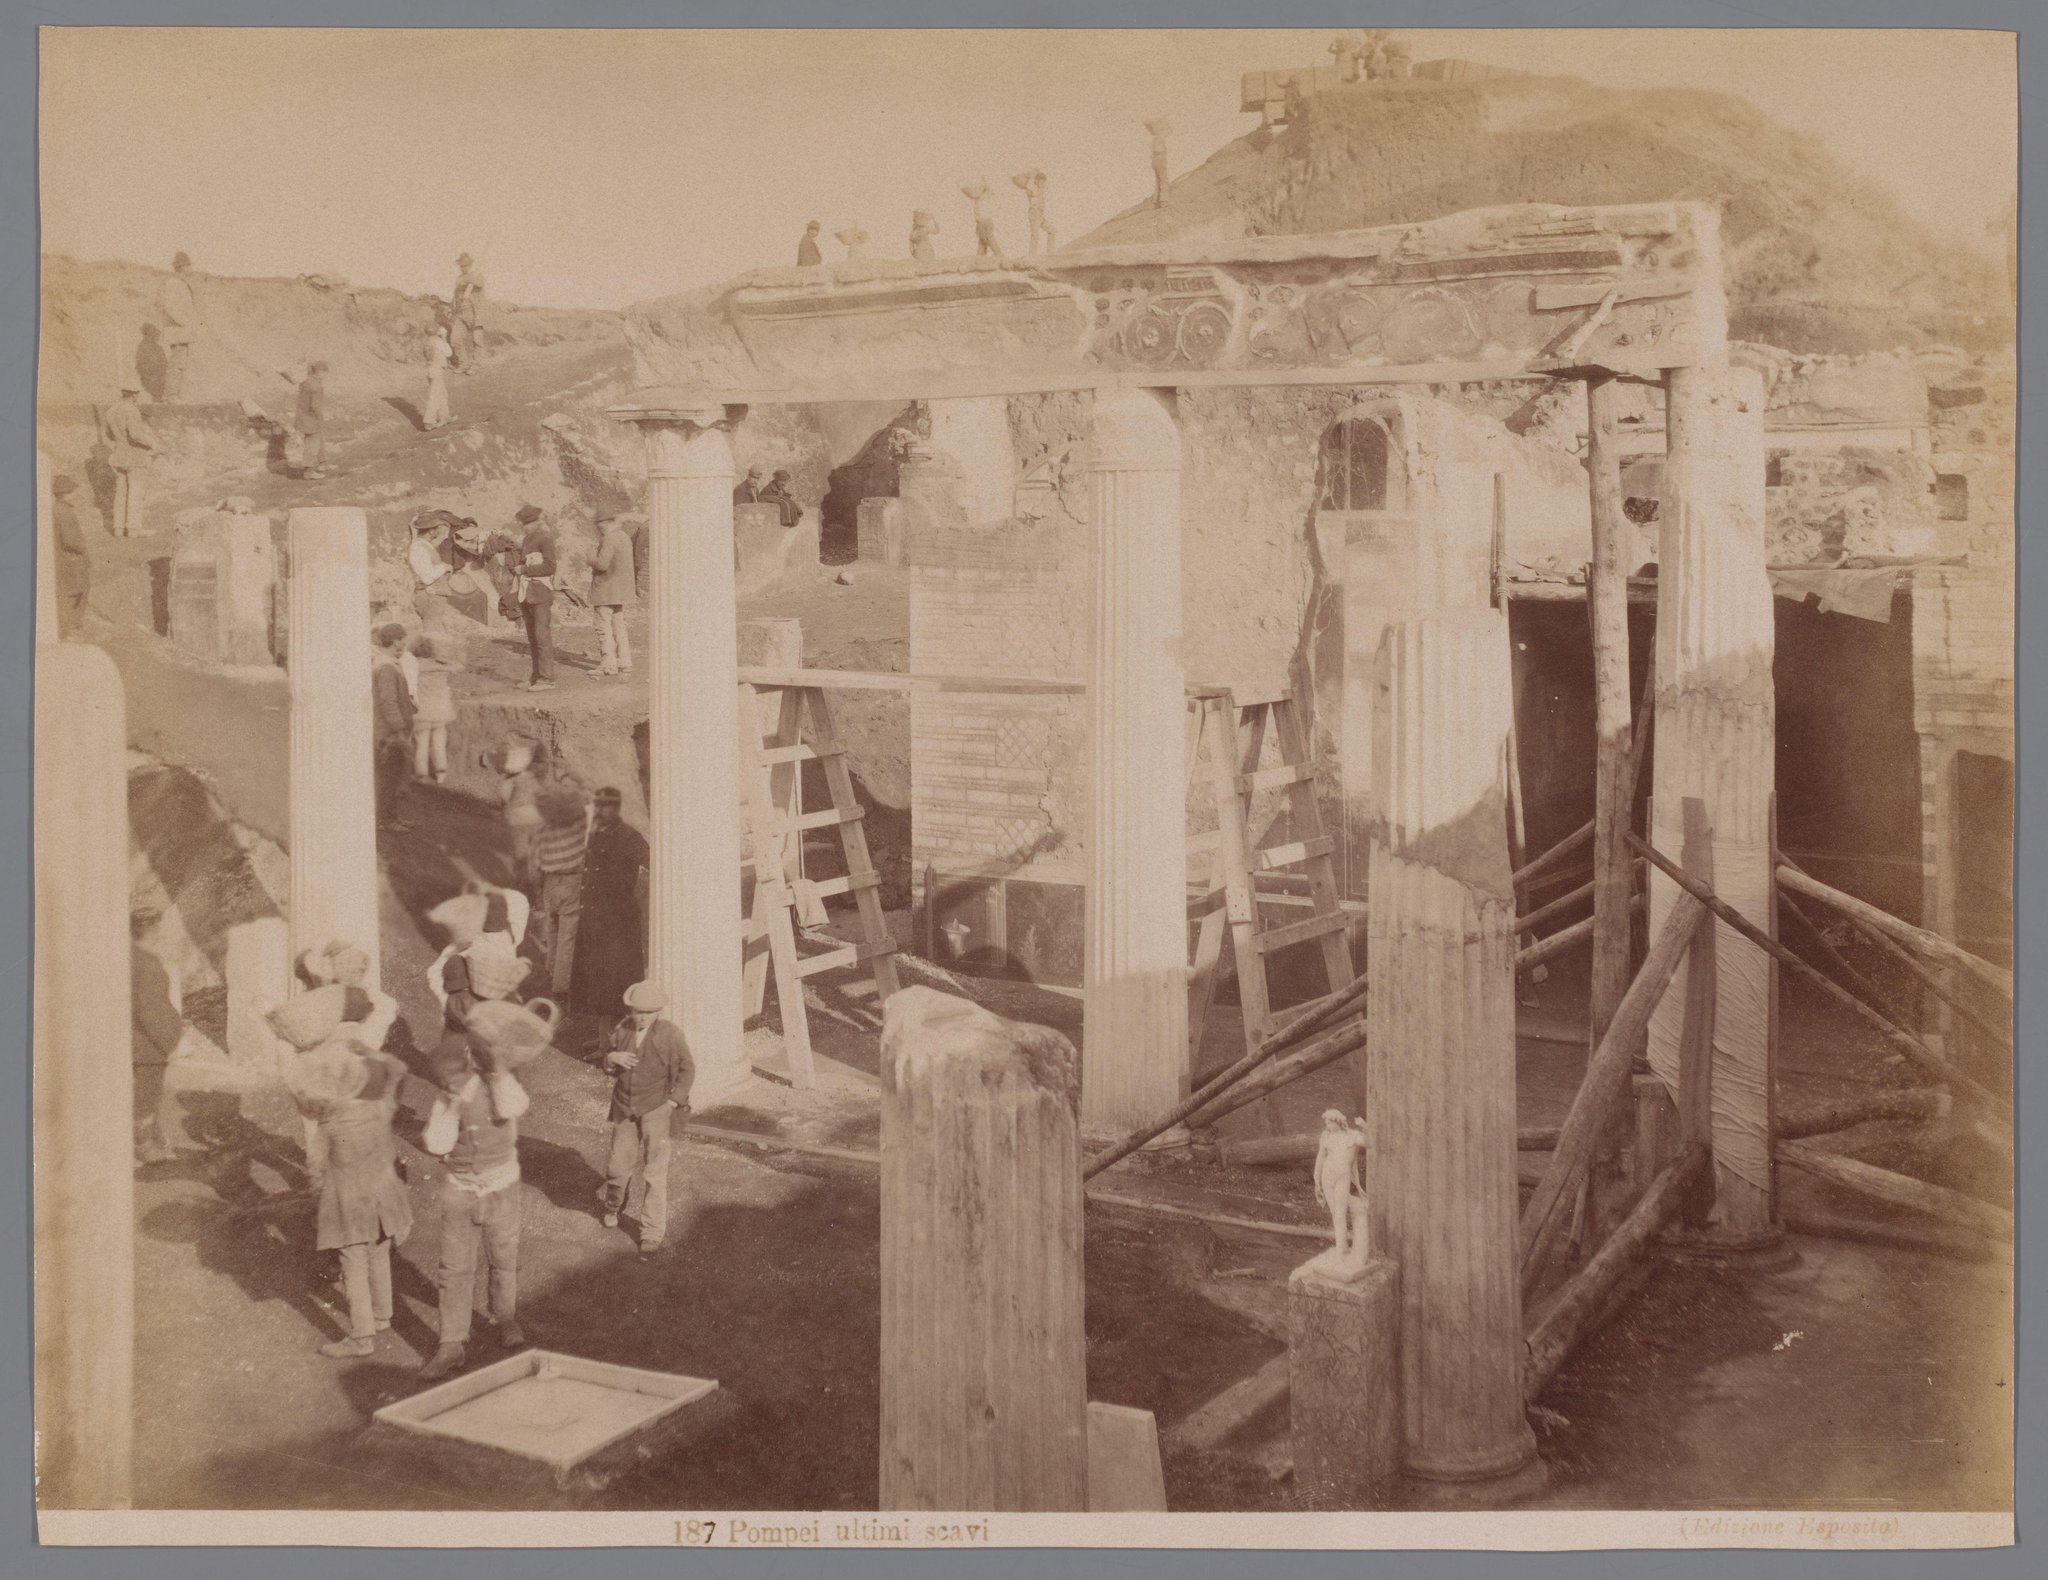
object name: photograph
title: Opgravingen te Pompeï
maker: Anonymous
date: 1870-1900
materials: paper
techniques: albumen print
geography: pompeii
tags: excavation ~ archaeology, pompeii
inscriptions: collector's mark: ‘VOSMAER’, number: ‘187’